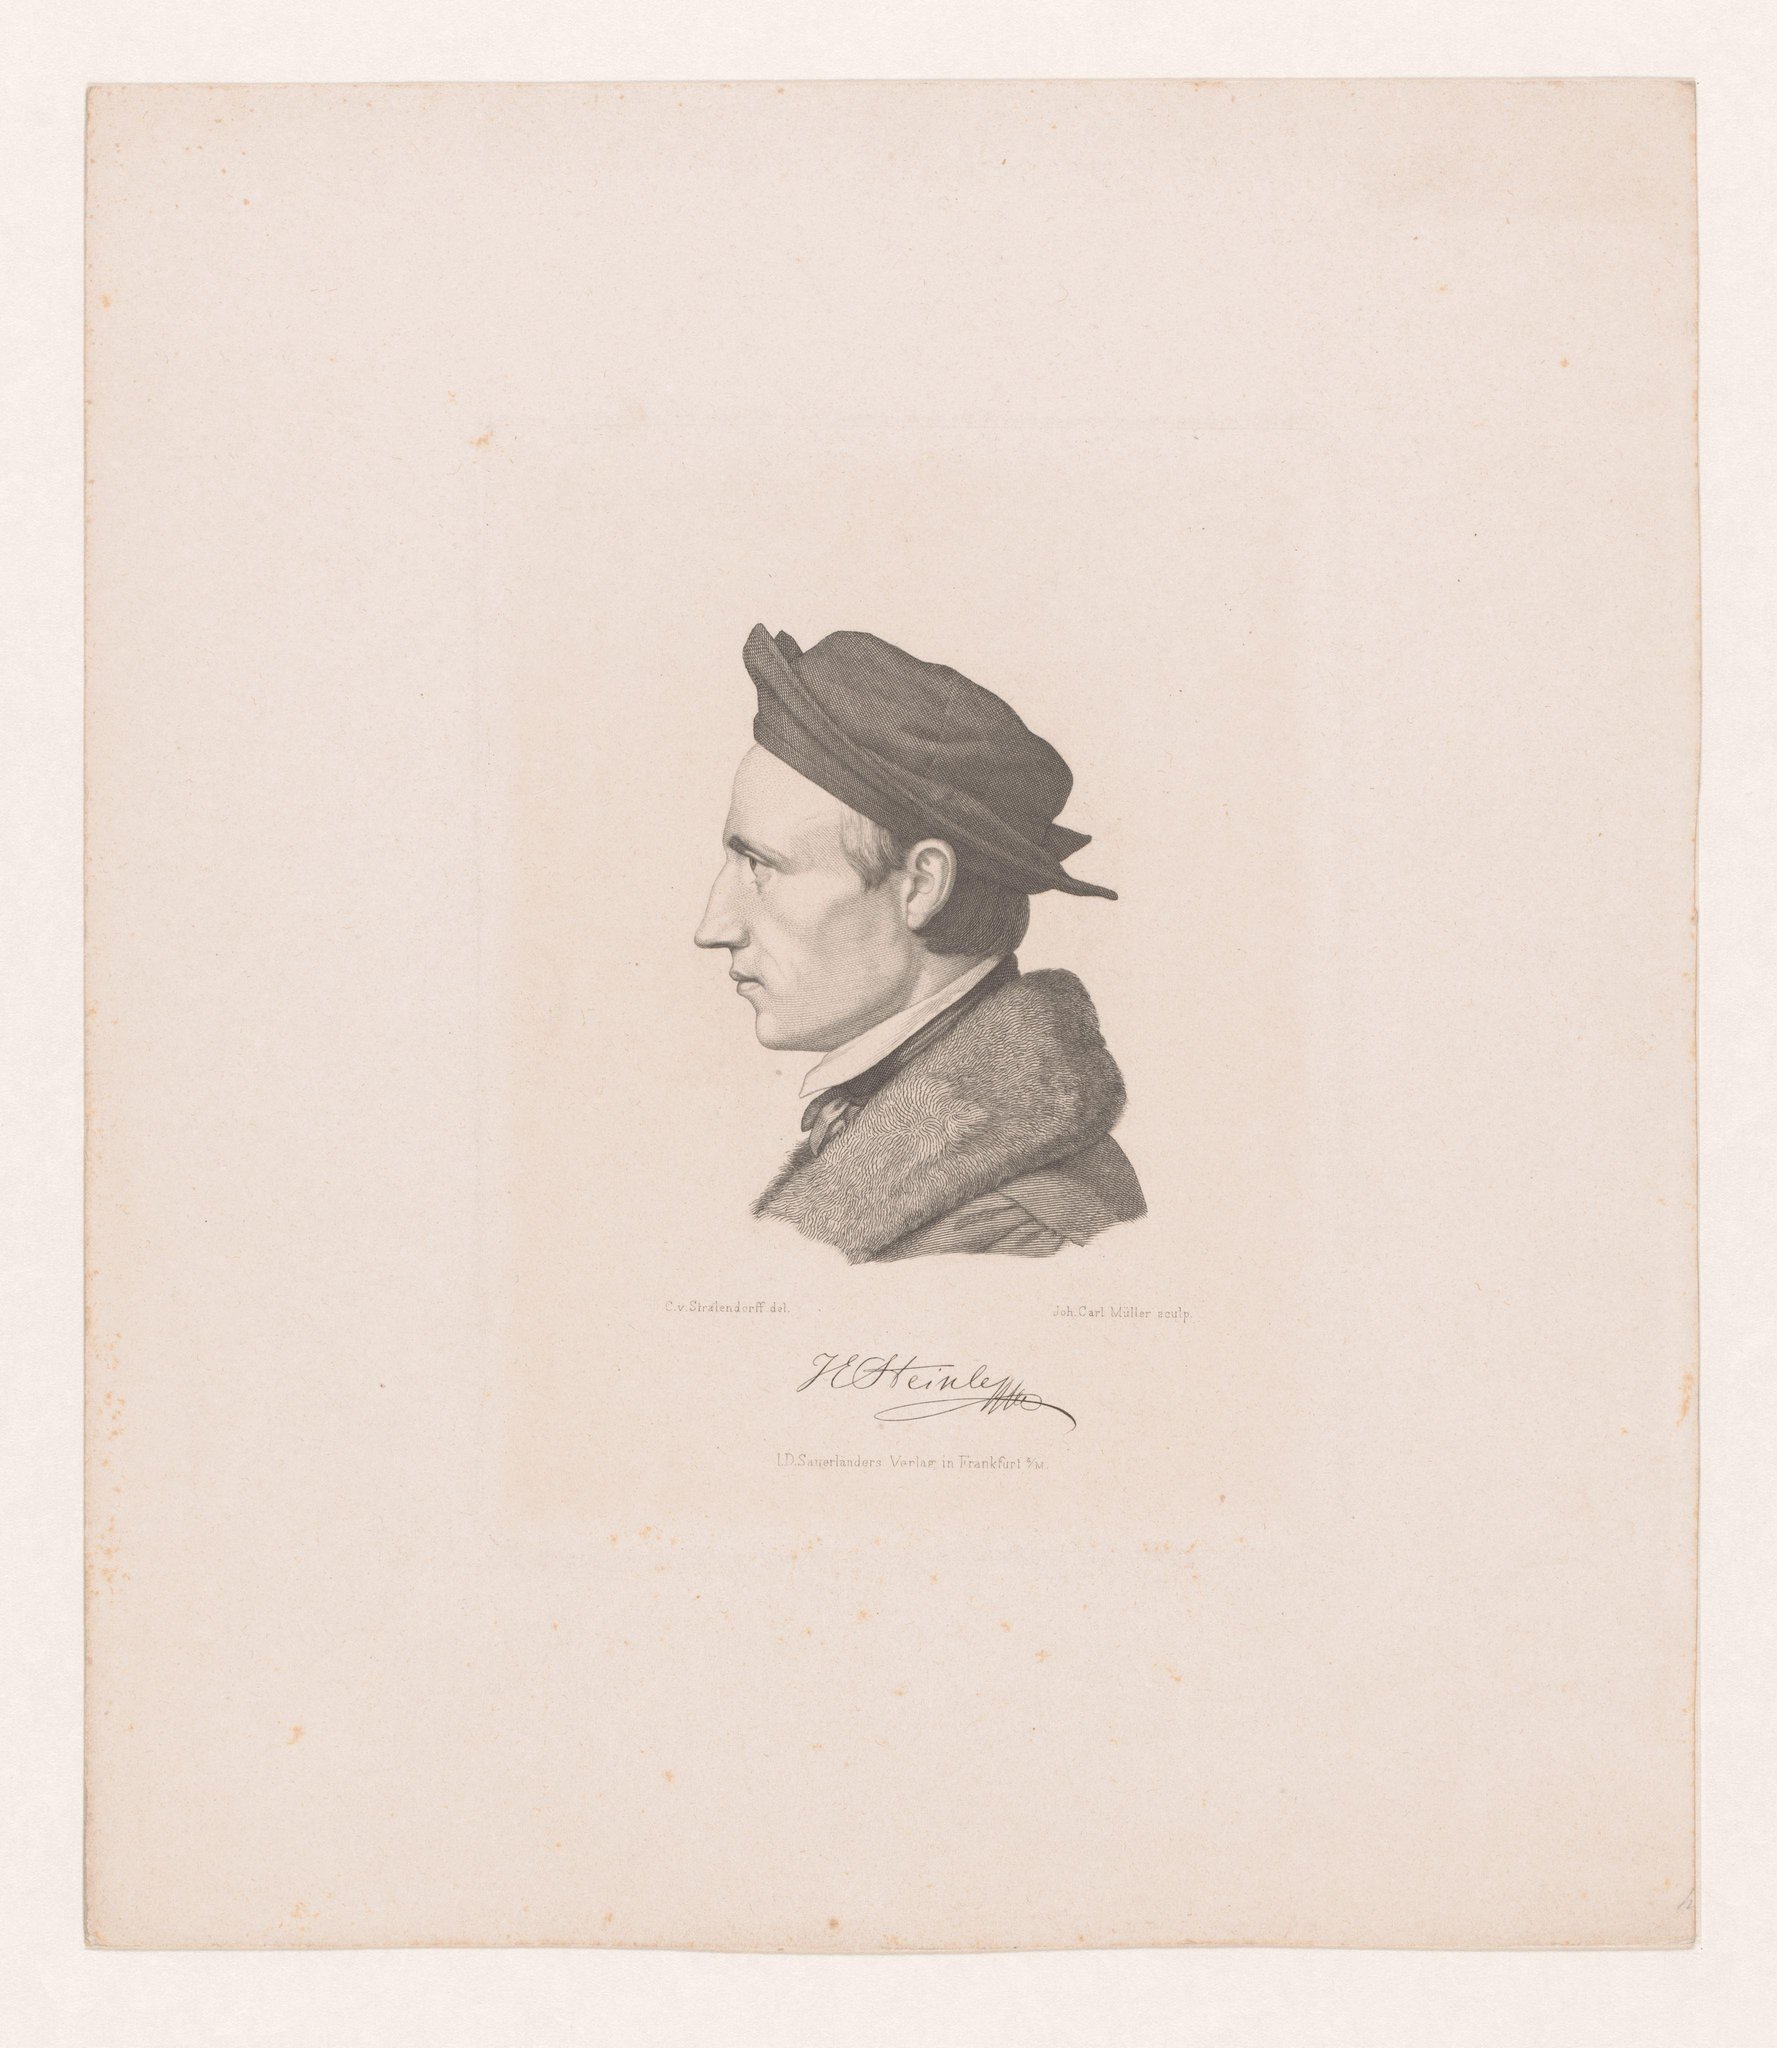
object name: print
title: Portret van Edward Jakob von Steinle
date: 1825-1872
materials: paper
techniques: engraving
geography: frankfurt am main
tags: draughtsman, edward jakob von steinle, historical persons, portrait, self-portrait of draughtsman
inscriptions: collector's mark: Lugt 2228